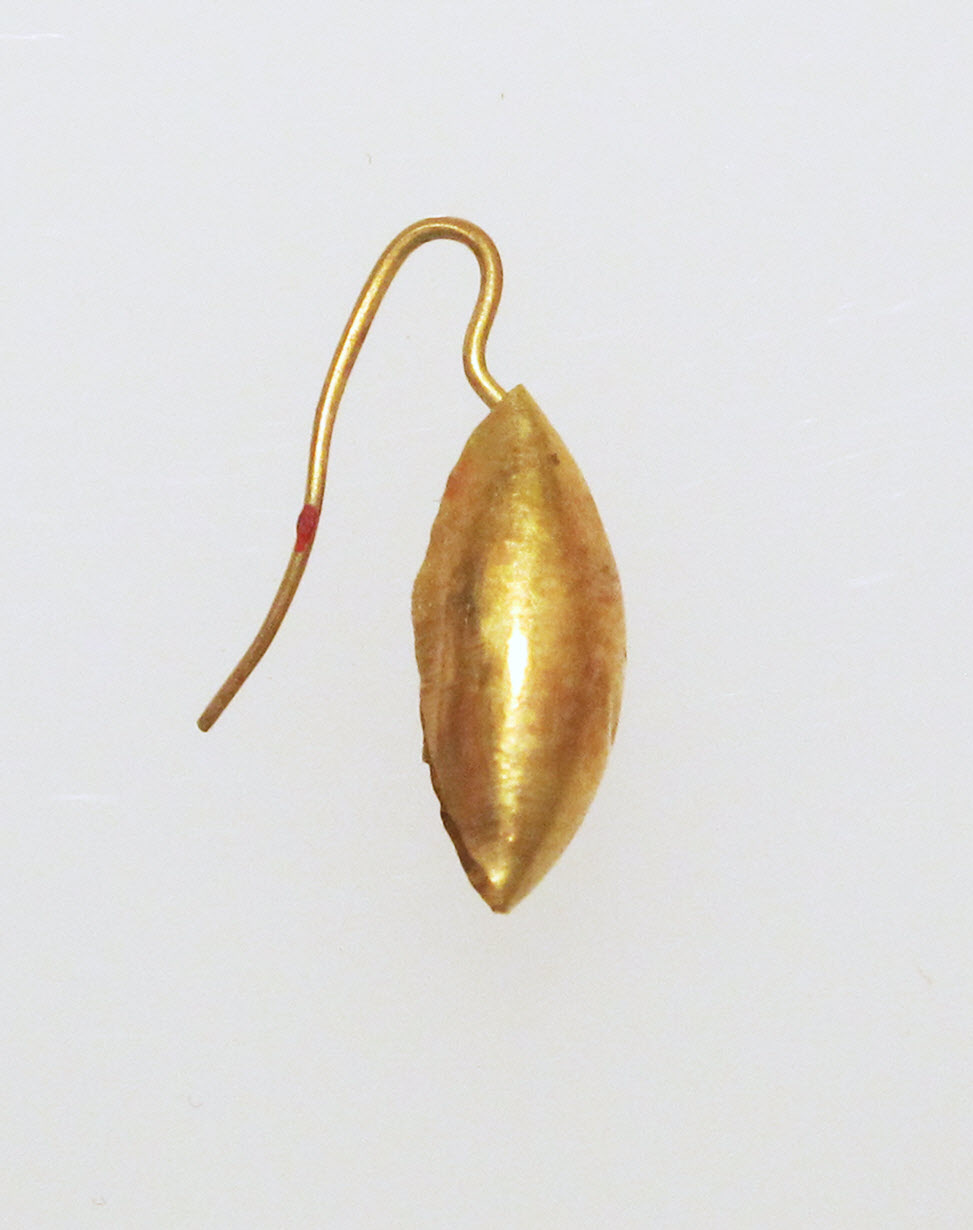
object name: earring hook type with sphere end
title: Earring-hook type with sphere ends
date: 7000 BCE-330 CE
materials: gold